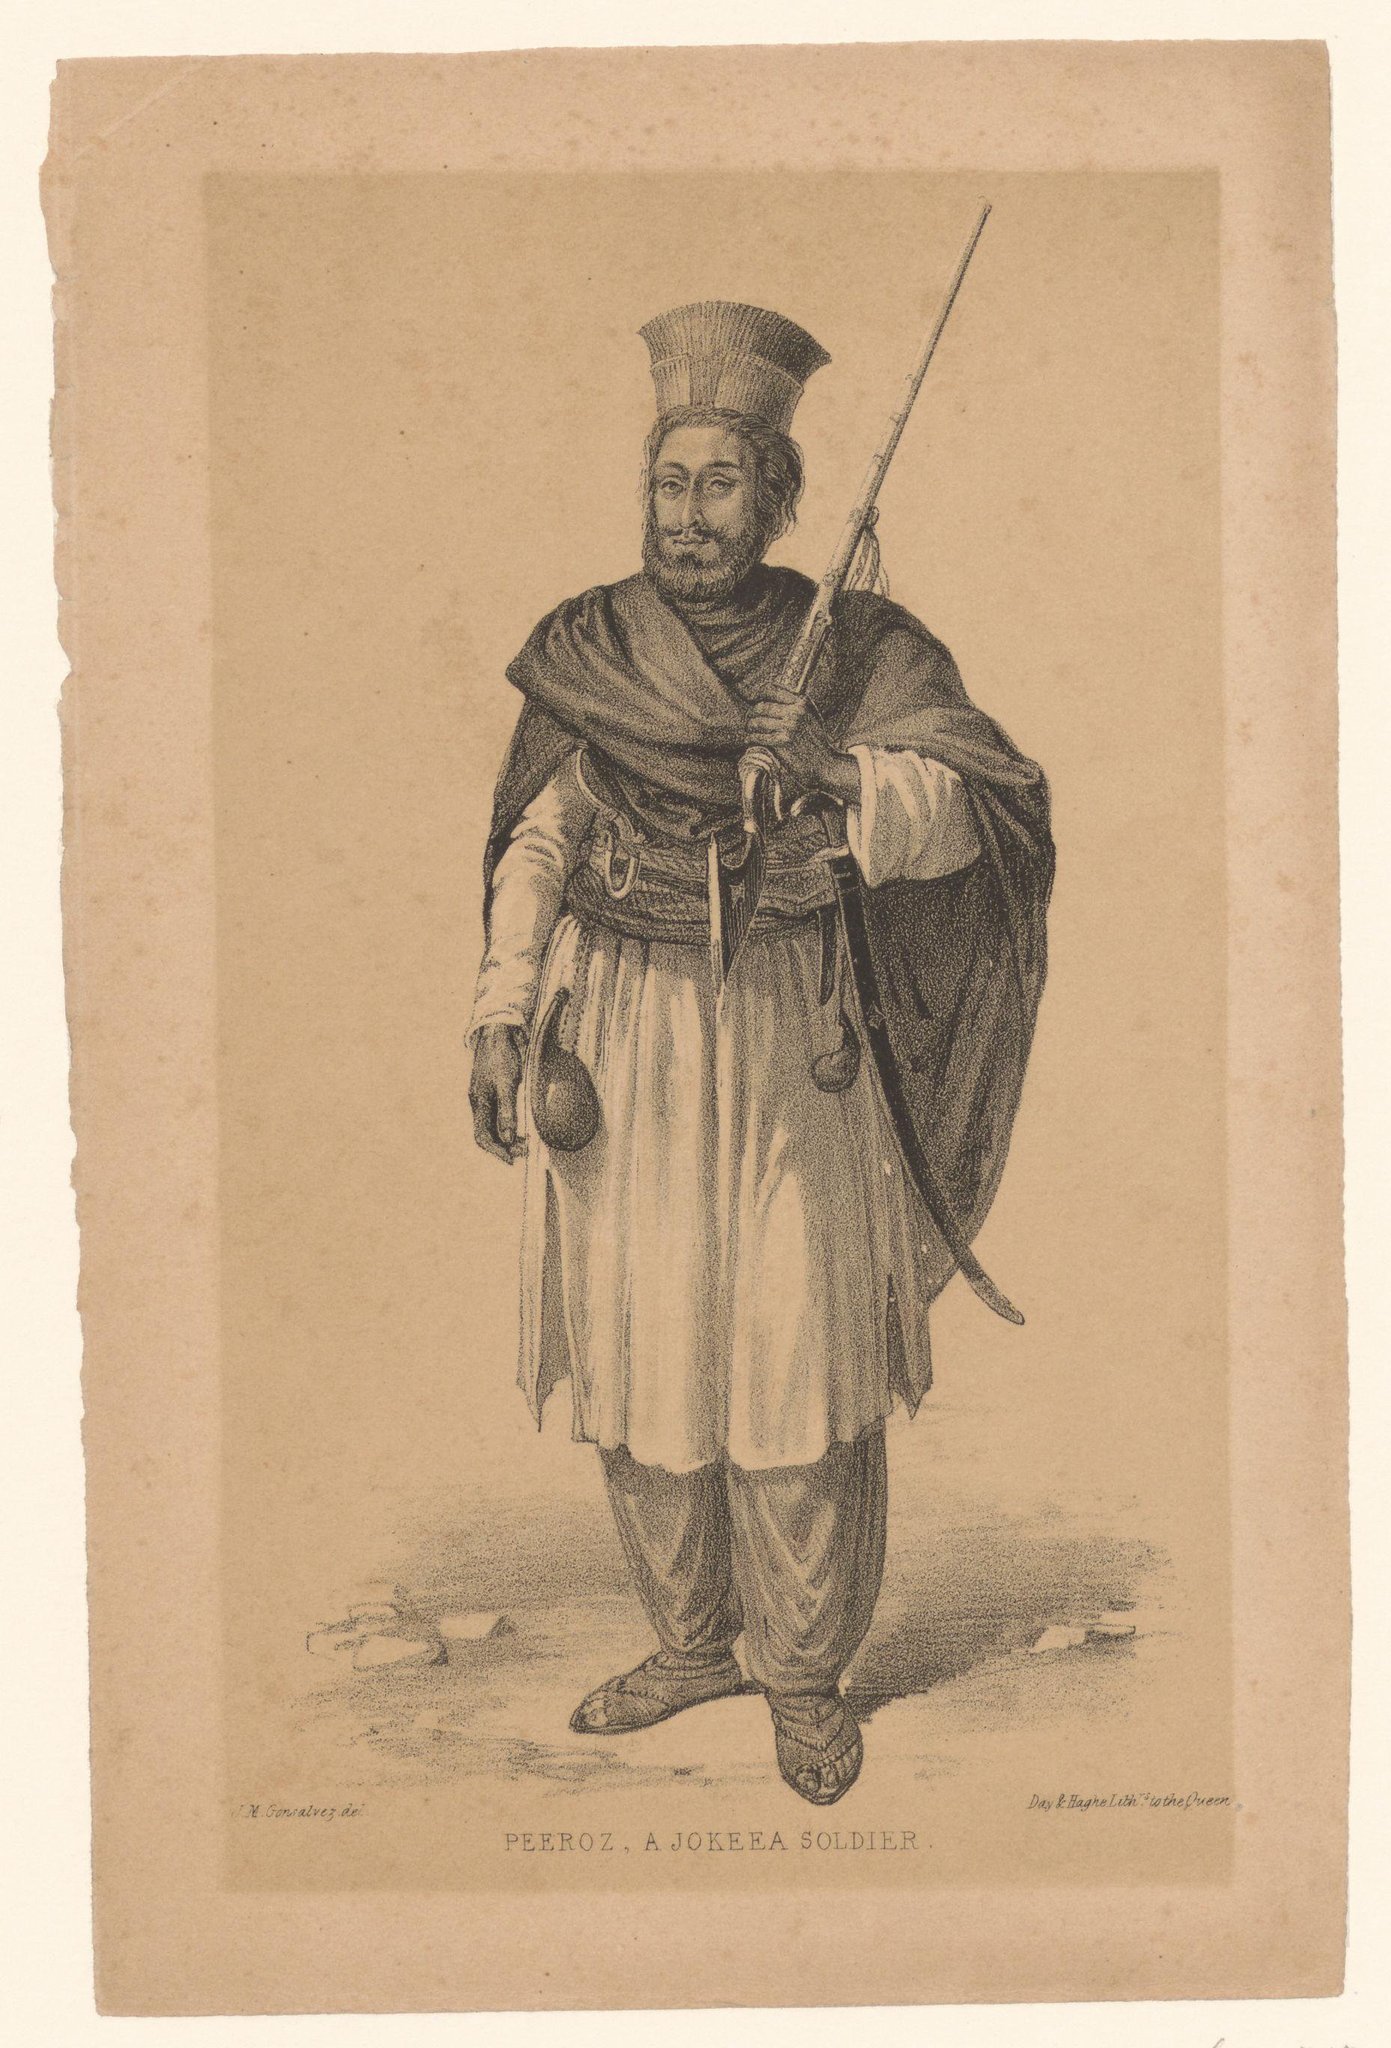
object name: book illustration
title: Portret van A Jokeea Soldier Peeroz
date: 1842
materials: paper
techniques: tone lithography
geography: london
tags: adult man, historical persons, weapons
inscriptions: collector's mark: Lugt 2228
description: Prent uit: Burnes, Alexander. Cabool: being a personal narrative of a journey to, and residence in that city, in the years 1836, 7, and 8. Londen: John Murray, 1842.